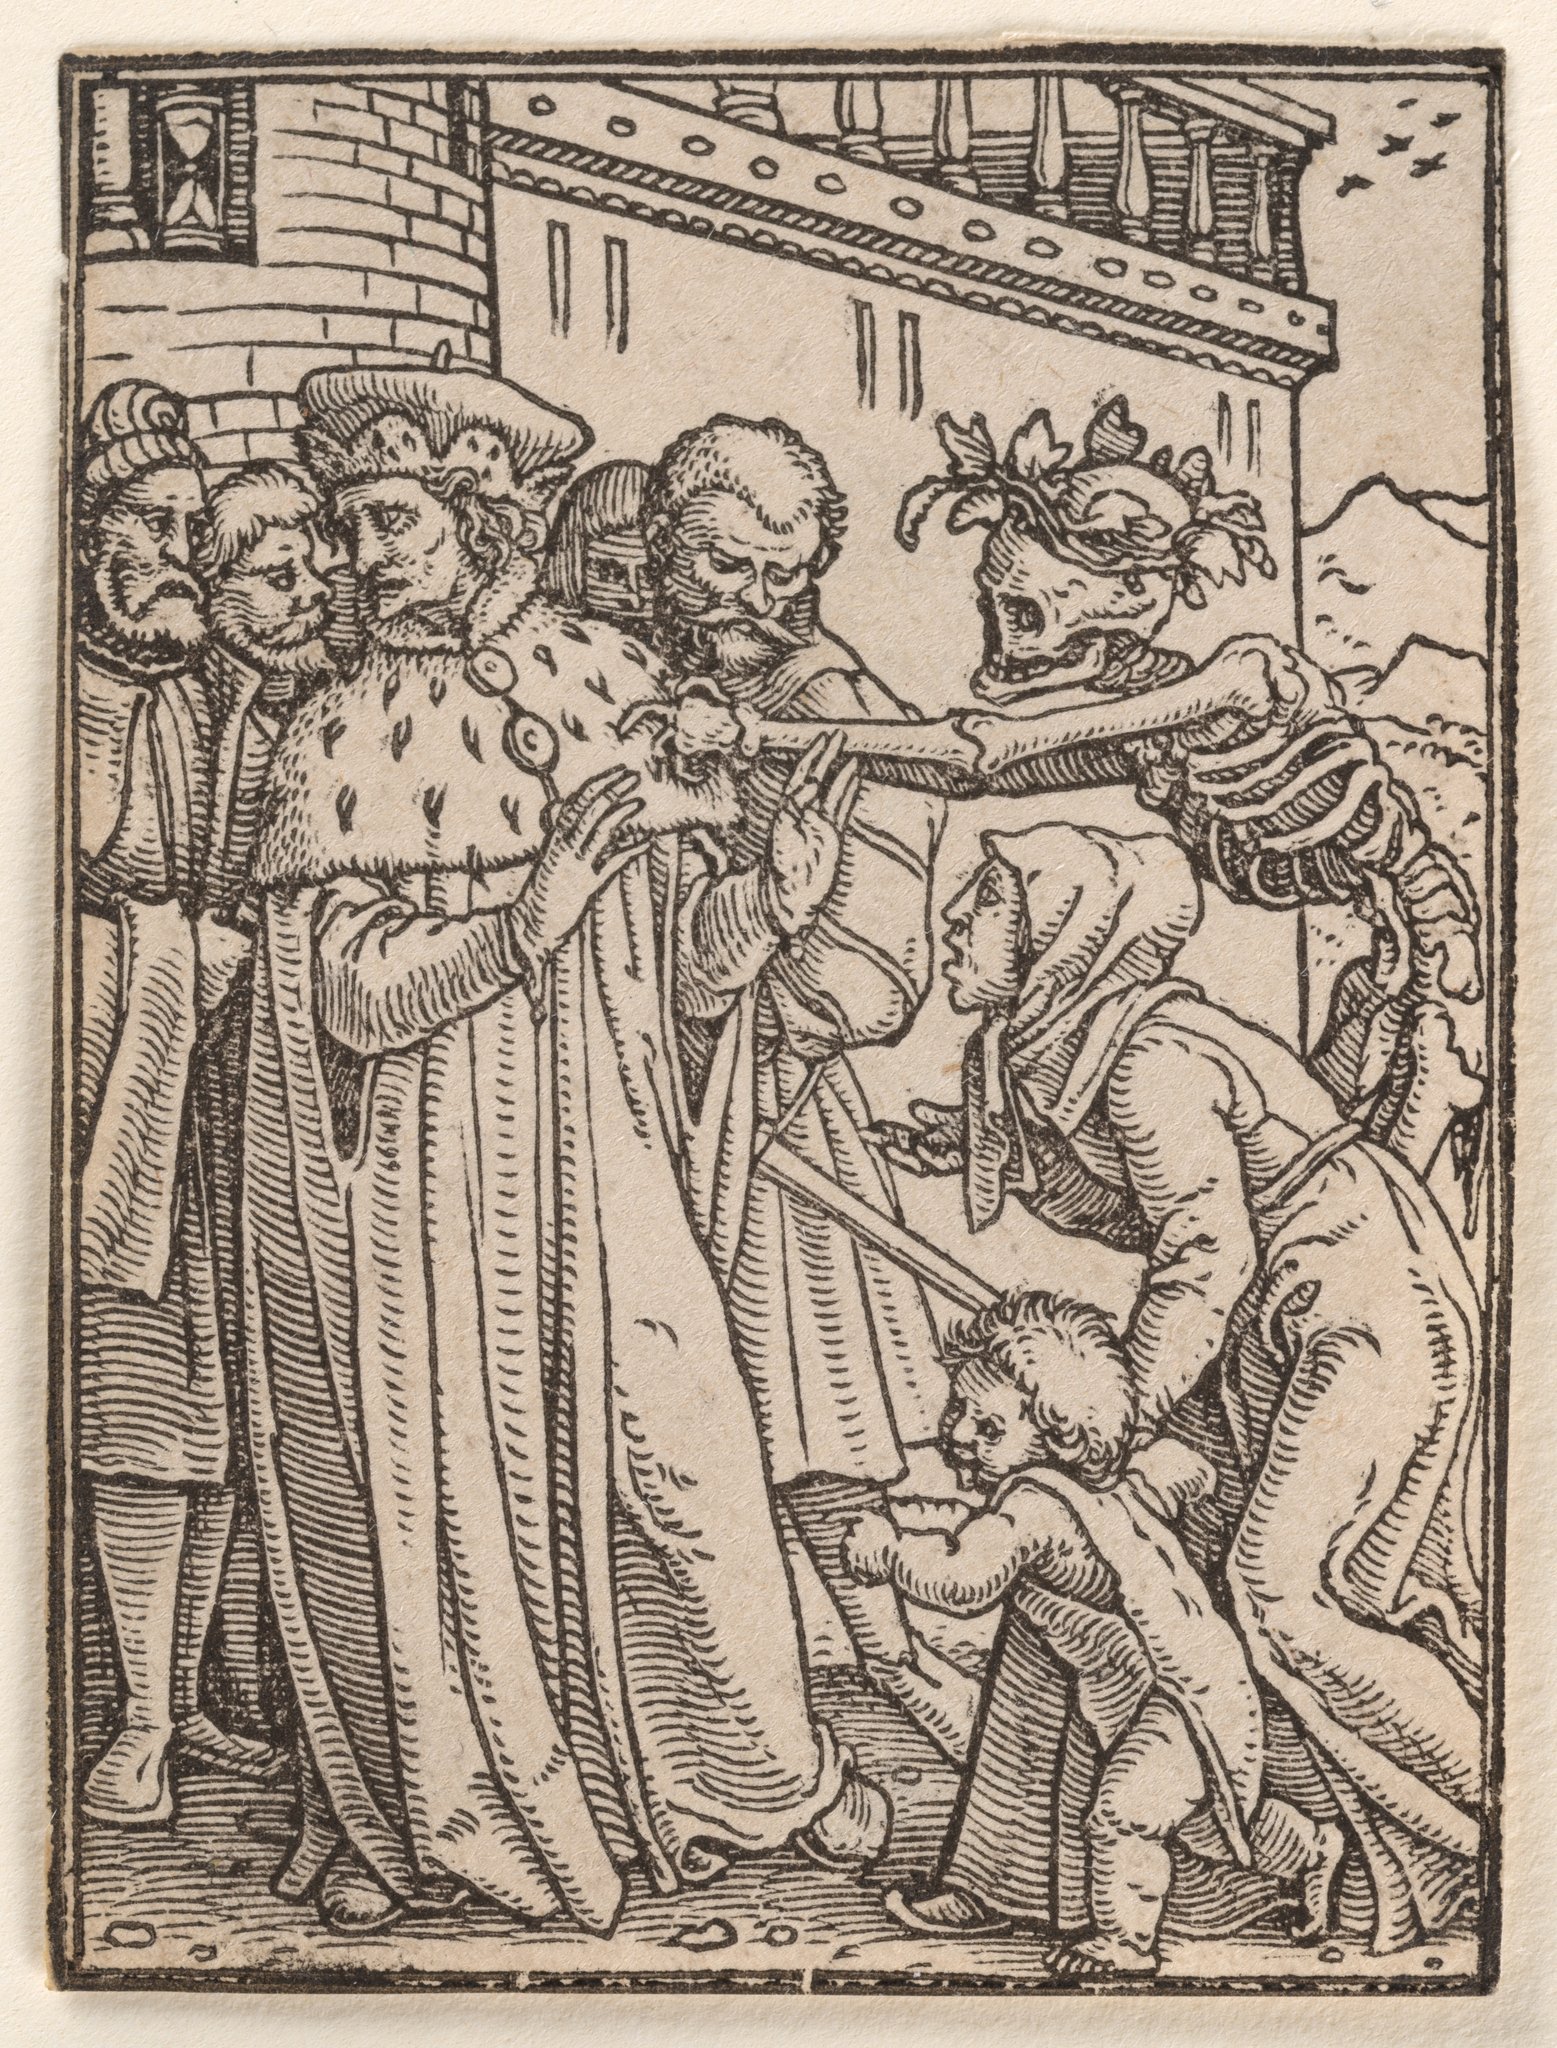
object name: print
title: The Duke, from "The Dance of Death"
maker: hans holbein the younger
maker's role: artist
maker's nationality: german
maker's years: 1497-1543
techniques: woodcut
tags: skeletons,children,men